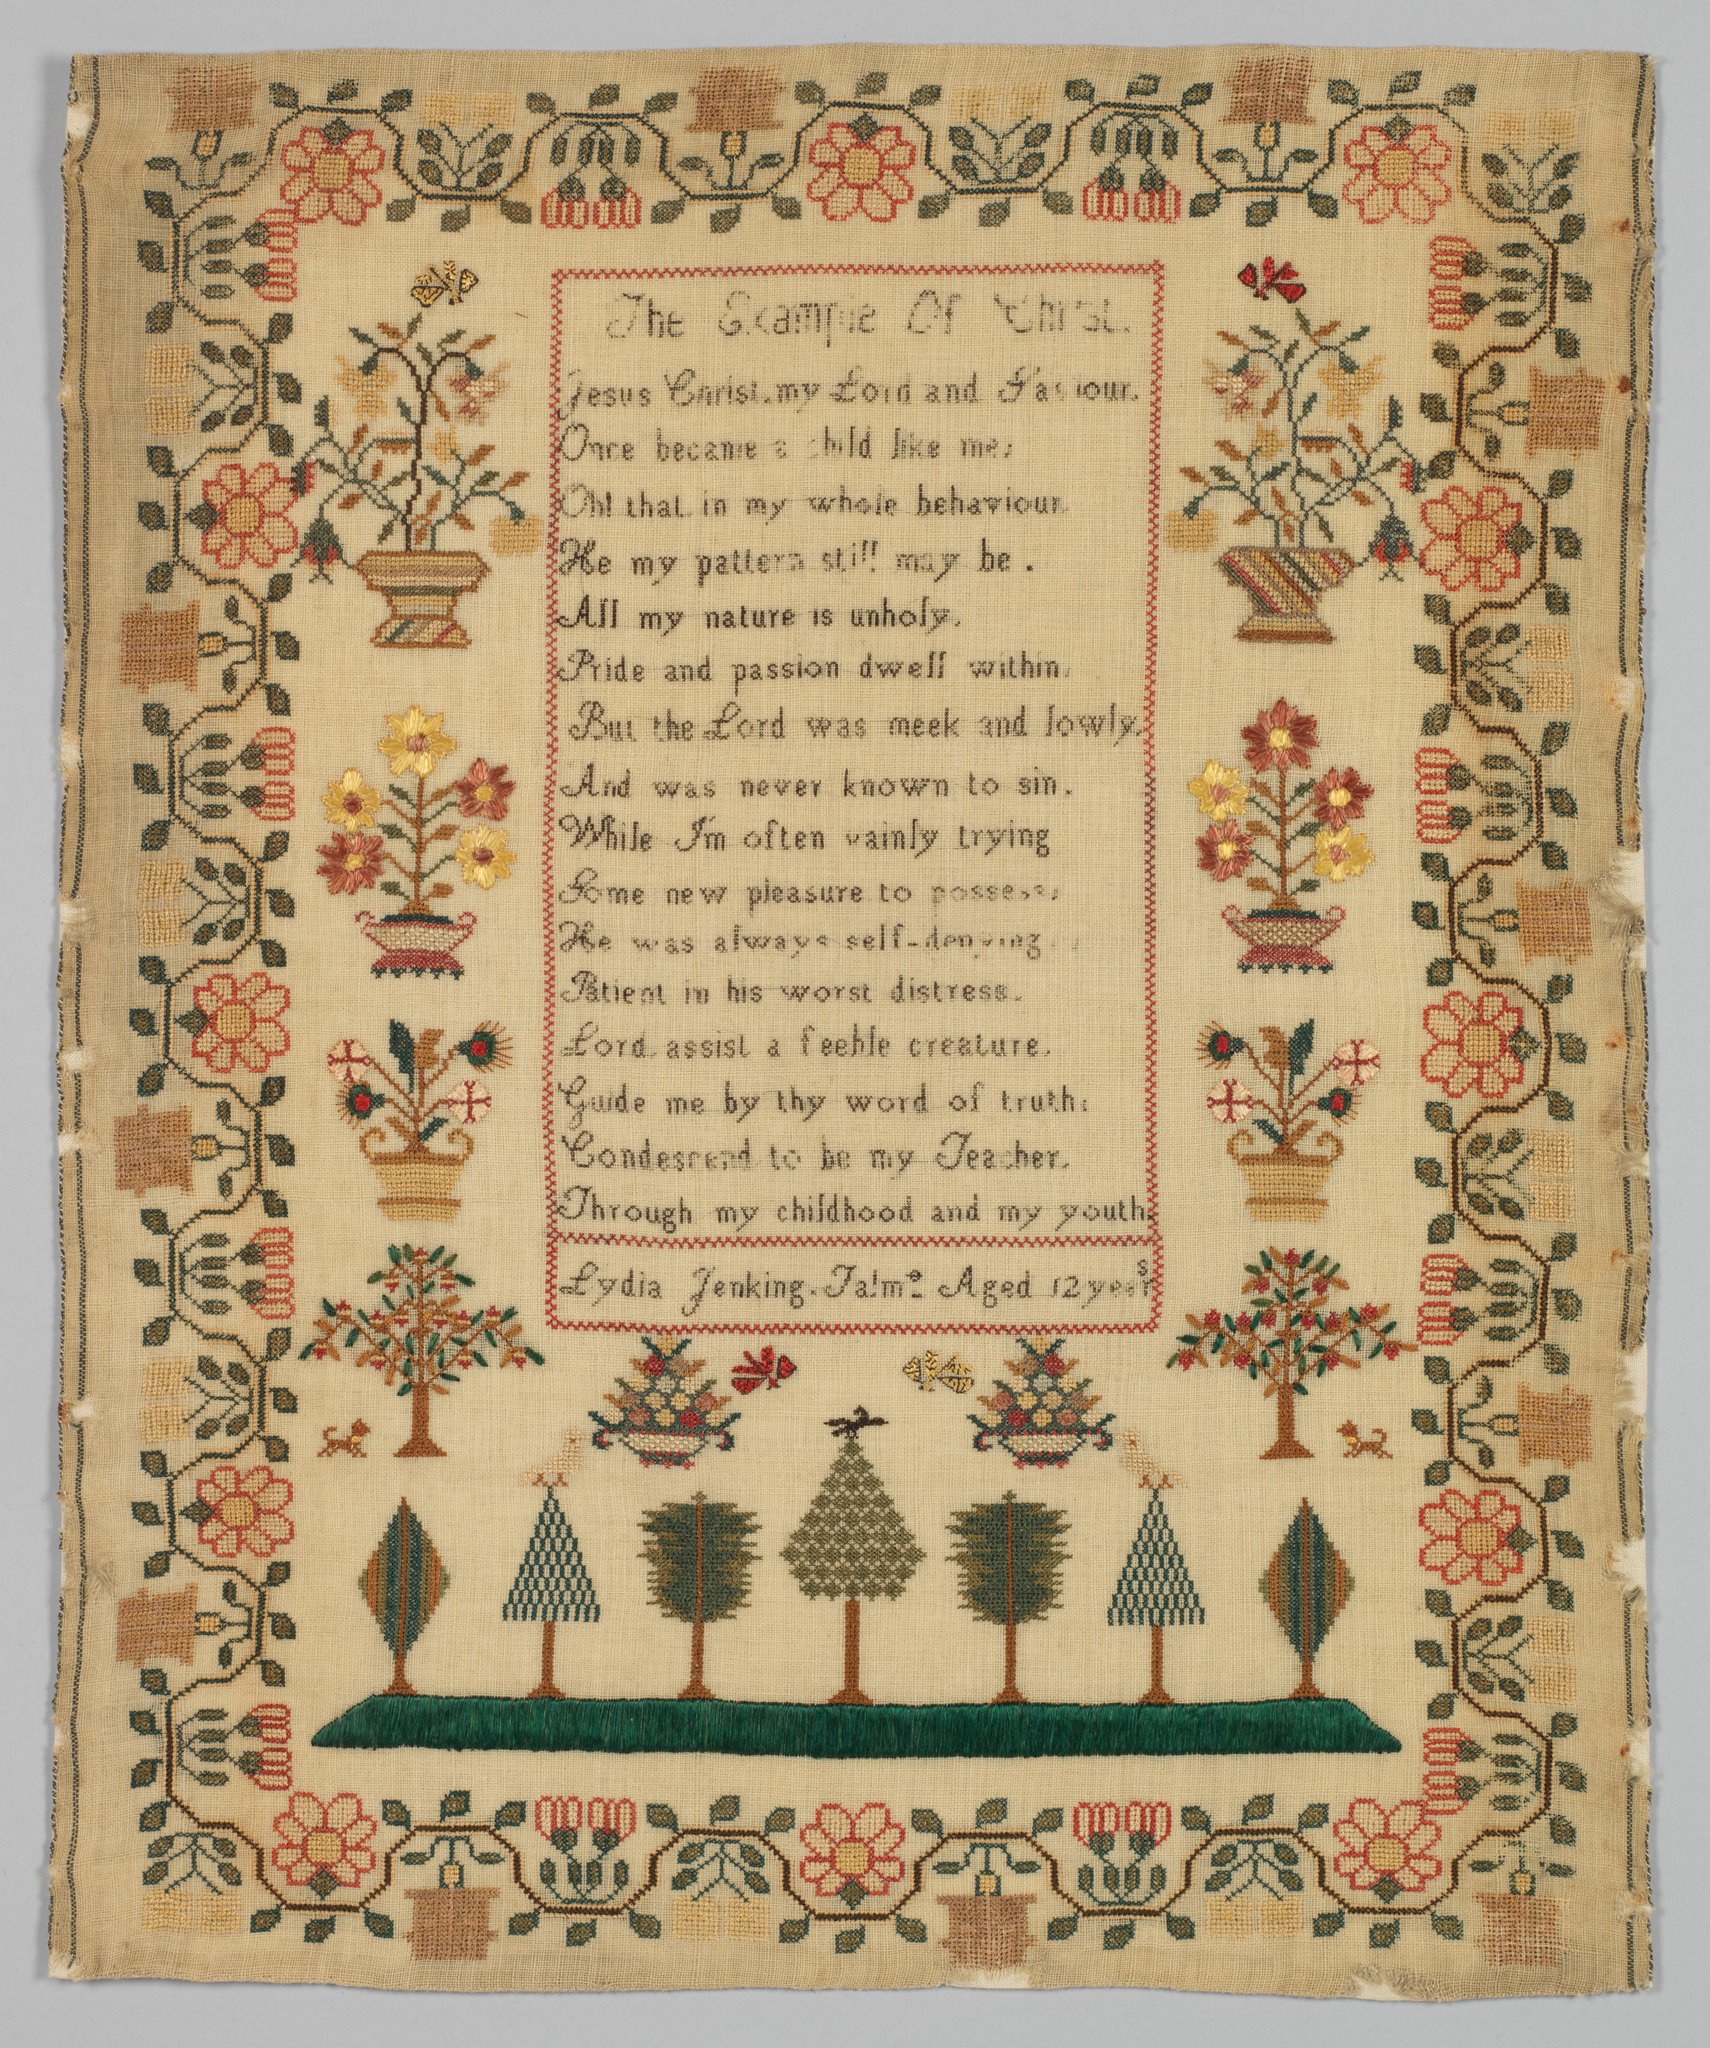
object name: sampler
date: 1801-1900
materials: canvas, silk, wool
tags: flowers,trees